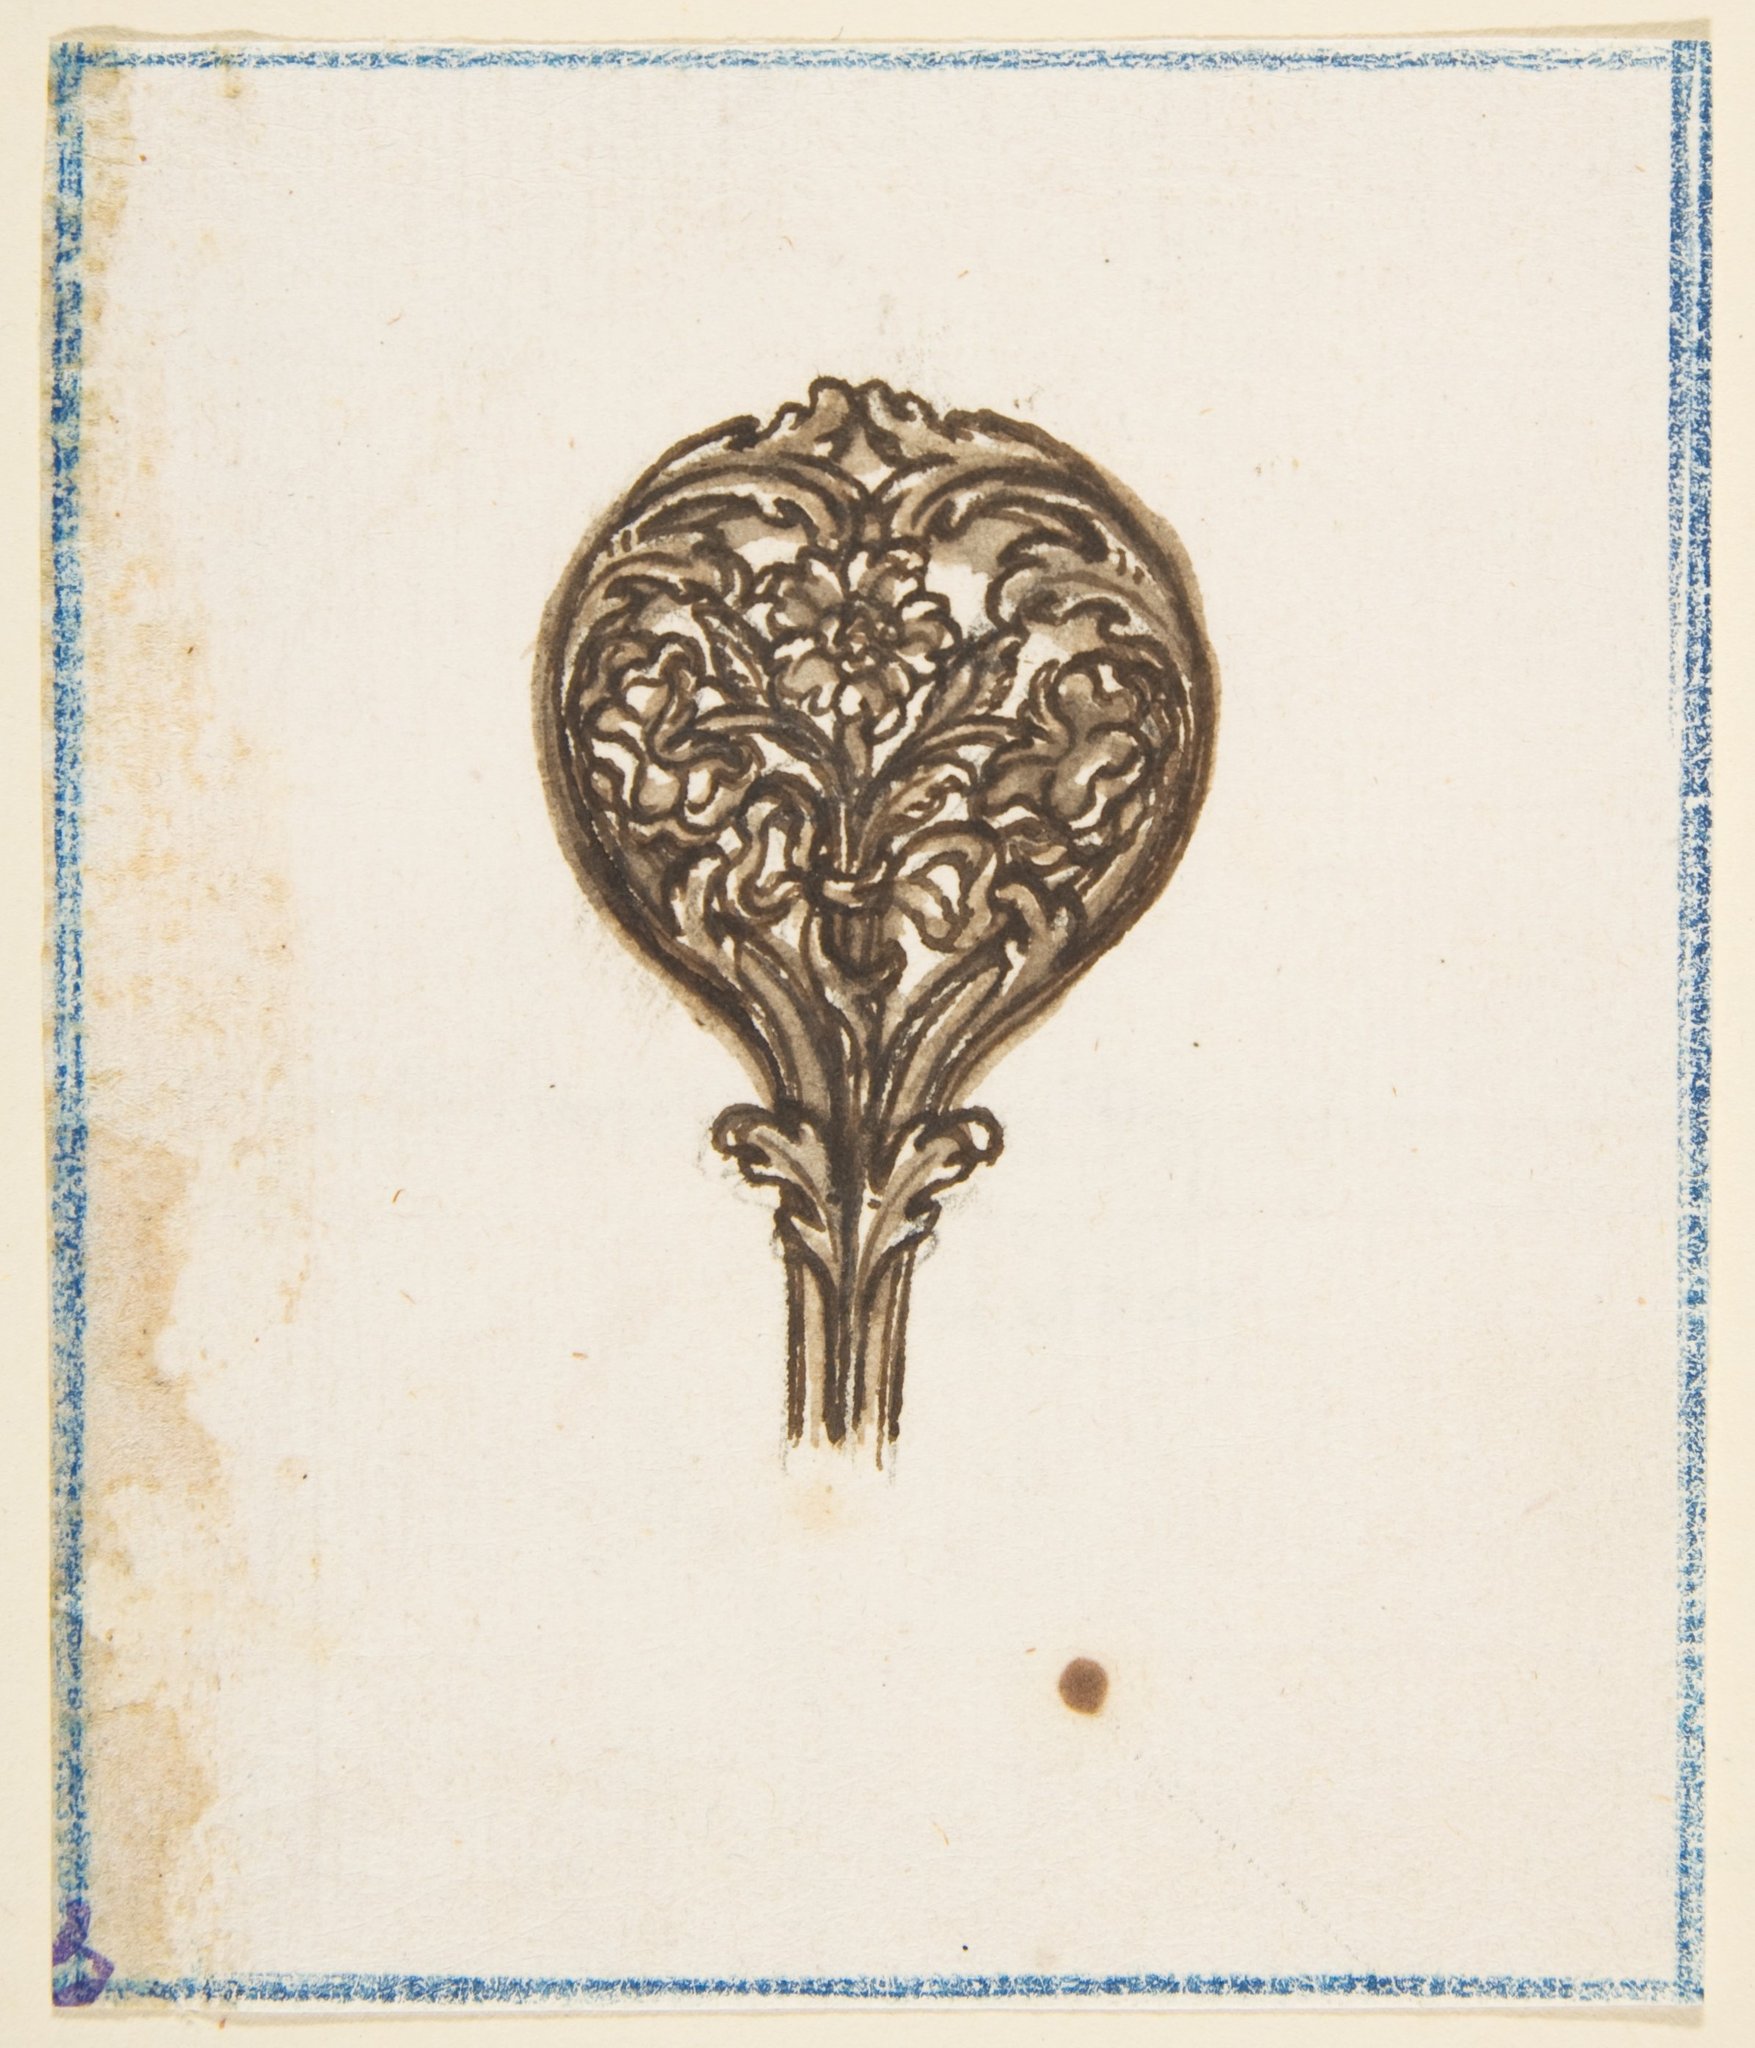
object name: drawing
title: Design for the Bow of a Key (?)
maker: anonymous, french, 19th century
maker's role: artist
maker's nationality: french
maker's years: 1800-1900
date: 1801-1900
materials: crayon, graphite, ink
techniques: pen, wash